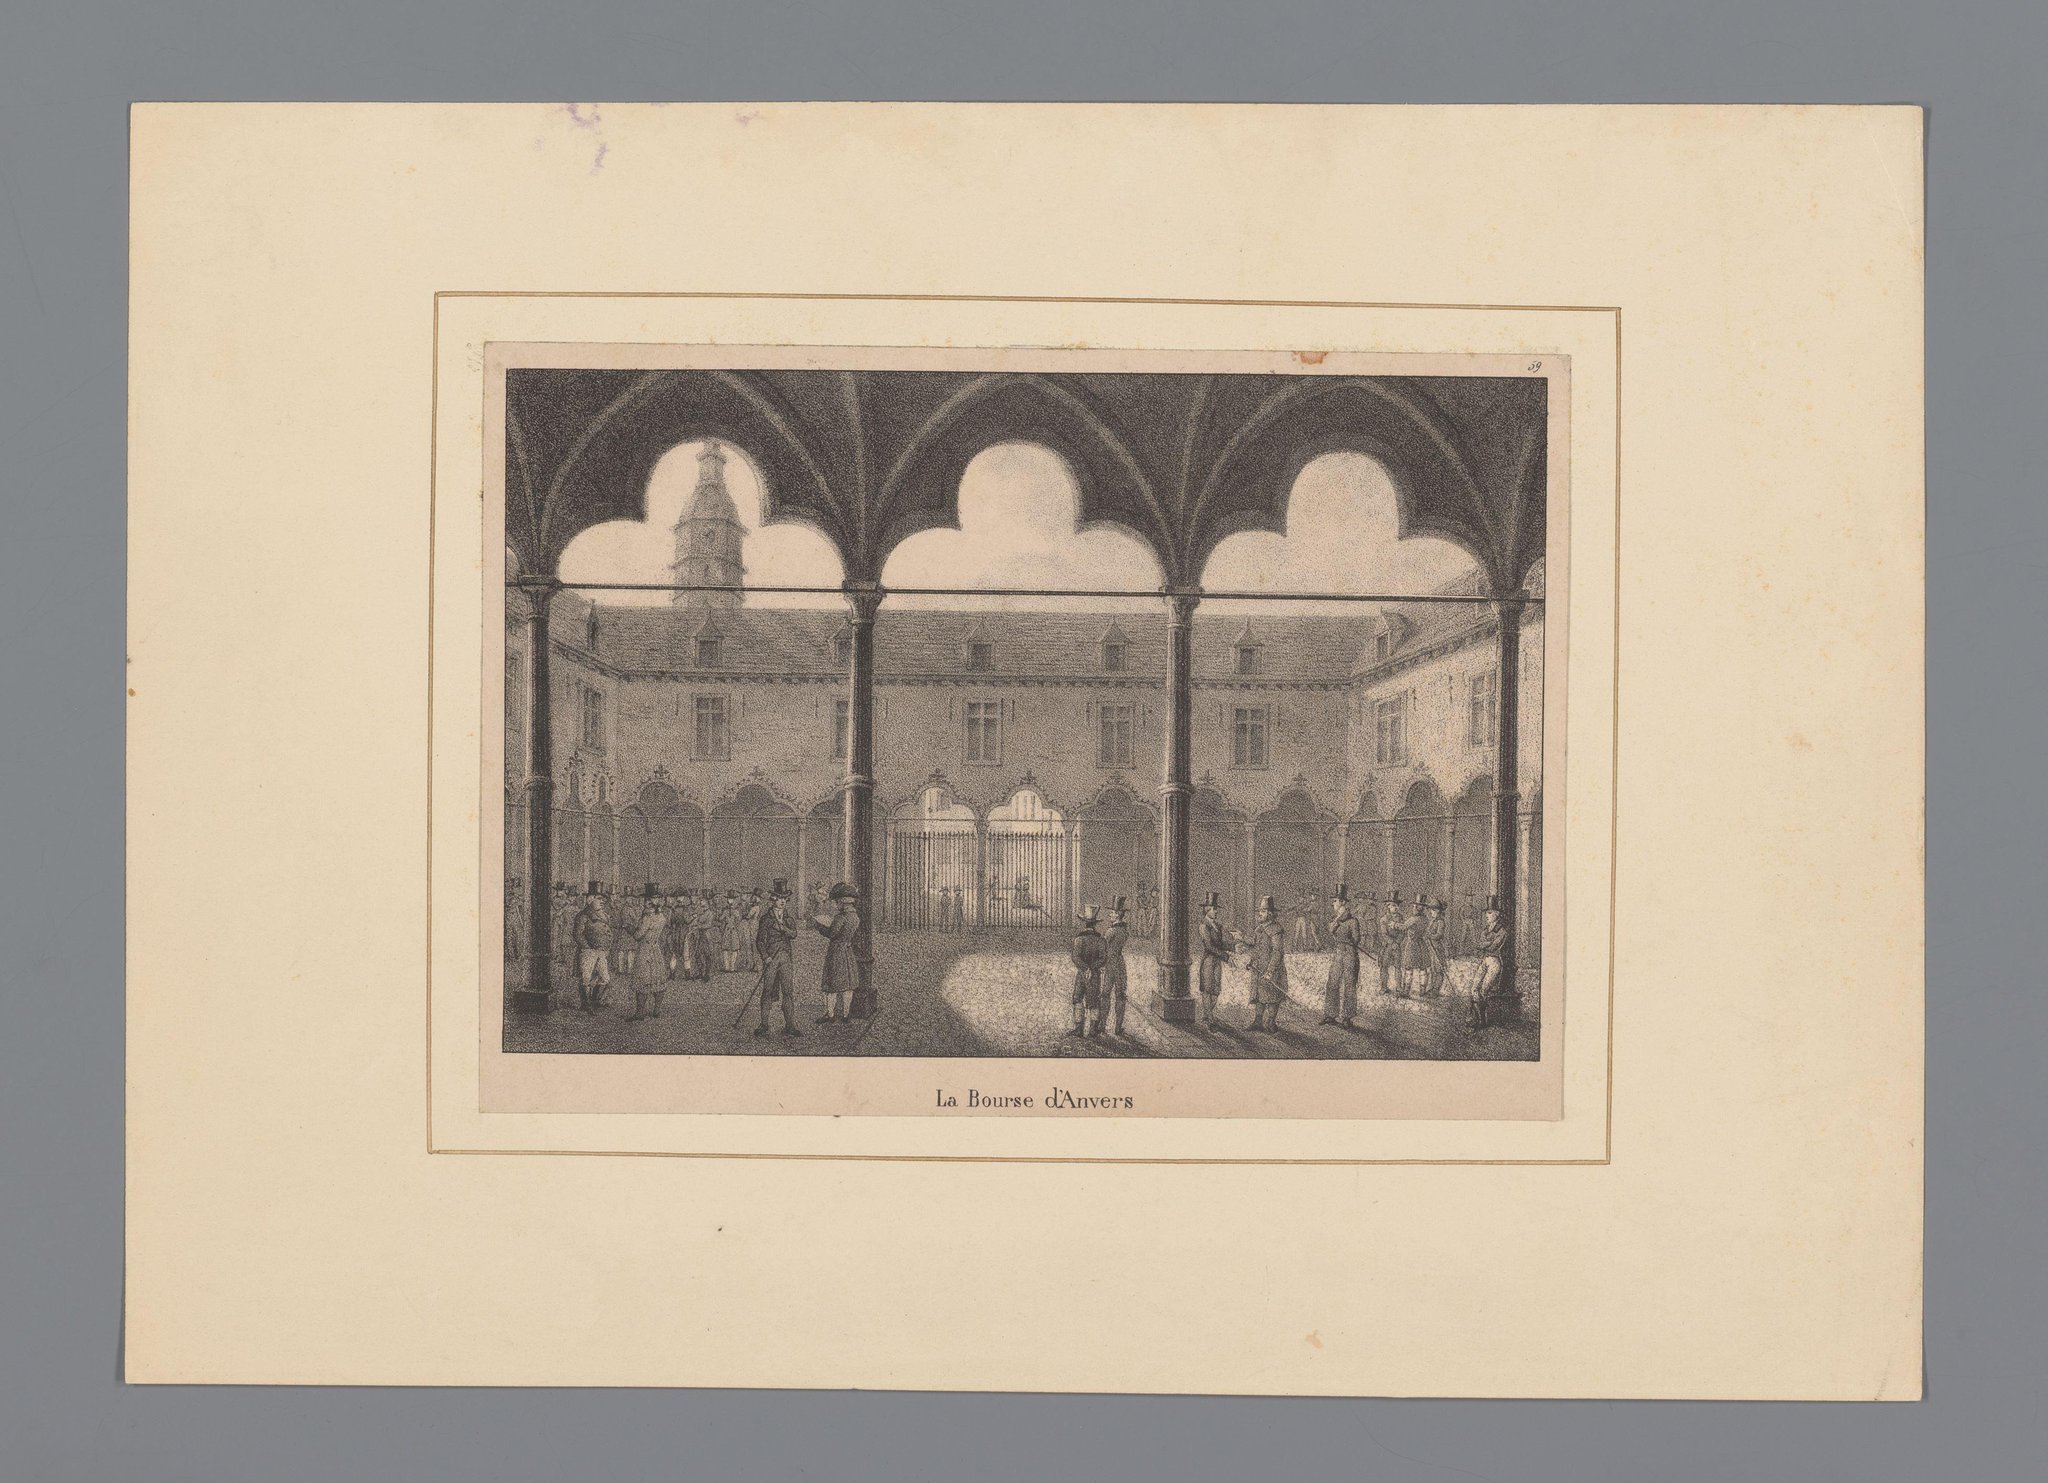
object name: book illustration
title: La Bourse d'Anvers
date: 1825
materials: paper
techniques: lithograph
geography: brussels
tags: exchange, bourse, antwerp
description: Prent uit: Cloet. Voyage Pittoresque dans le Royaume des Pays-Bas. Brussel: Jean Baptist Ambroise Marcellin Jobard, 1825.